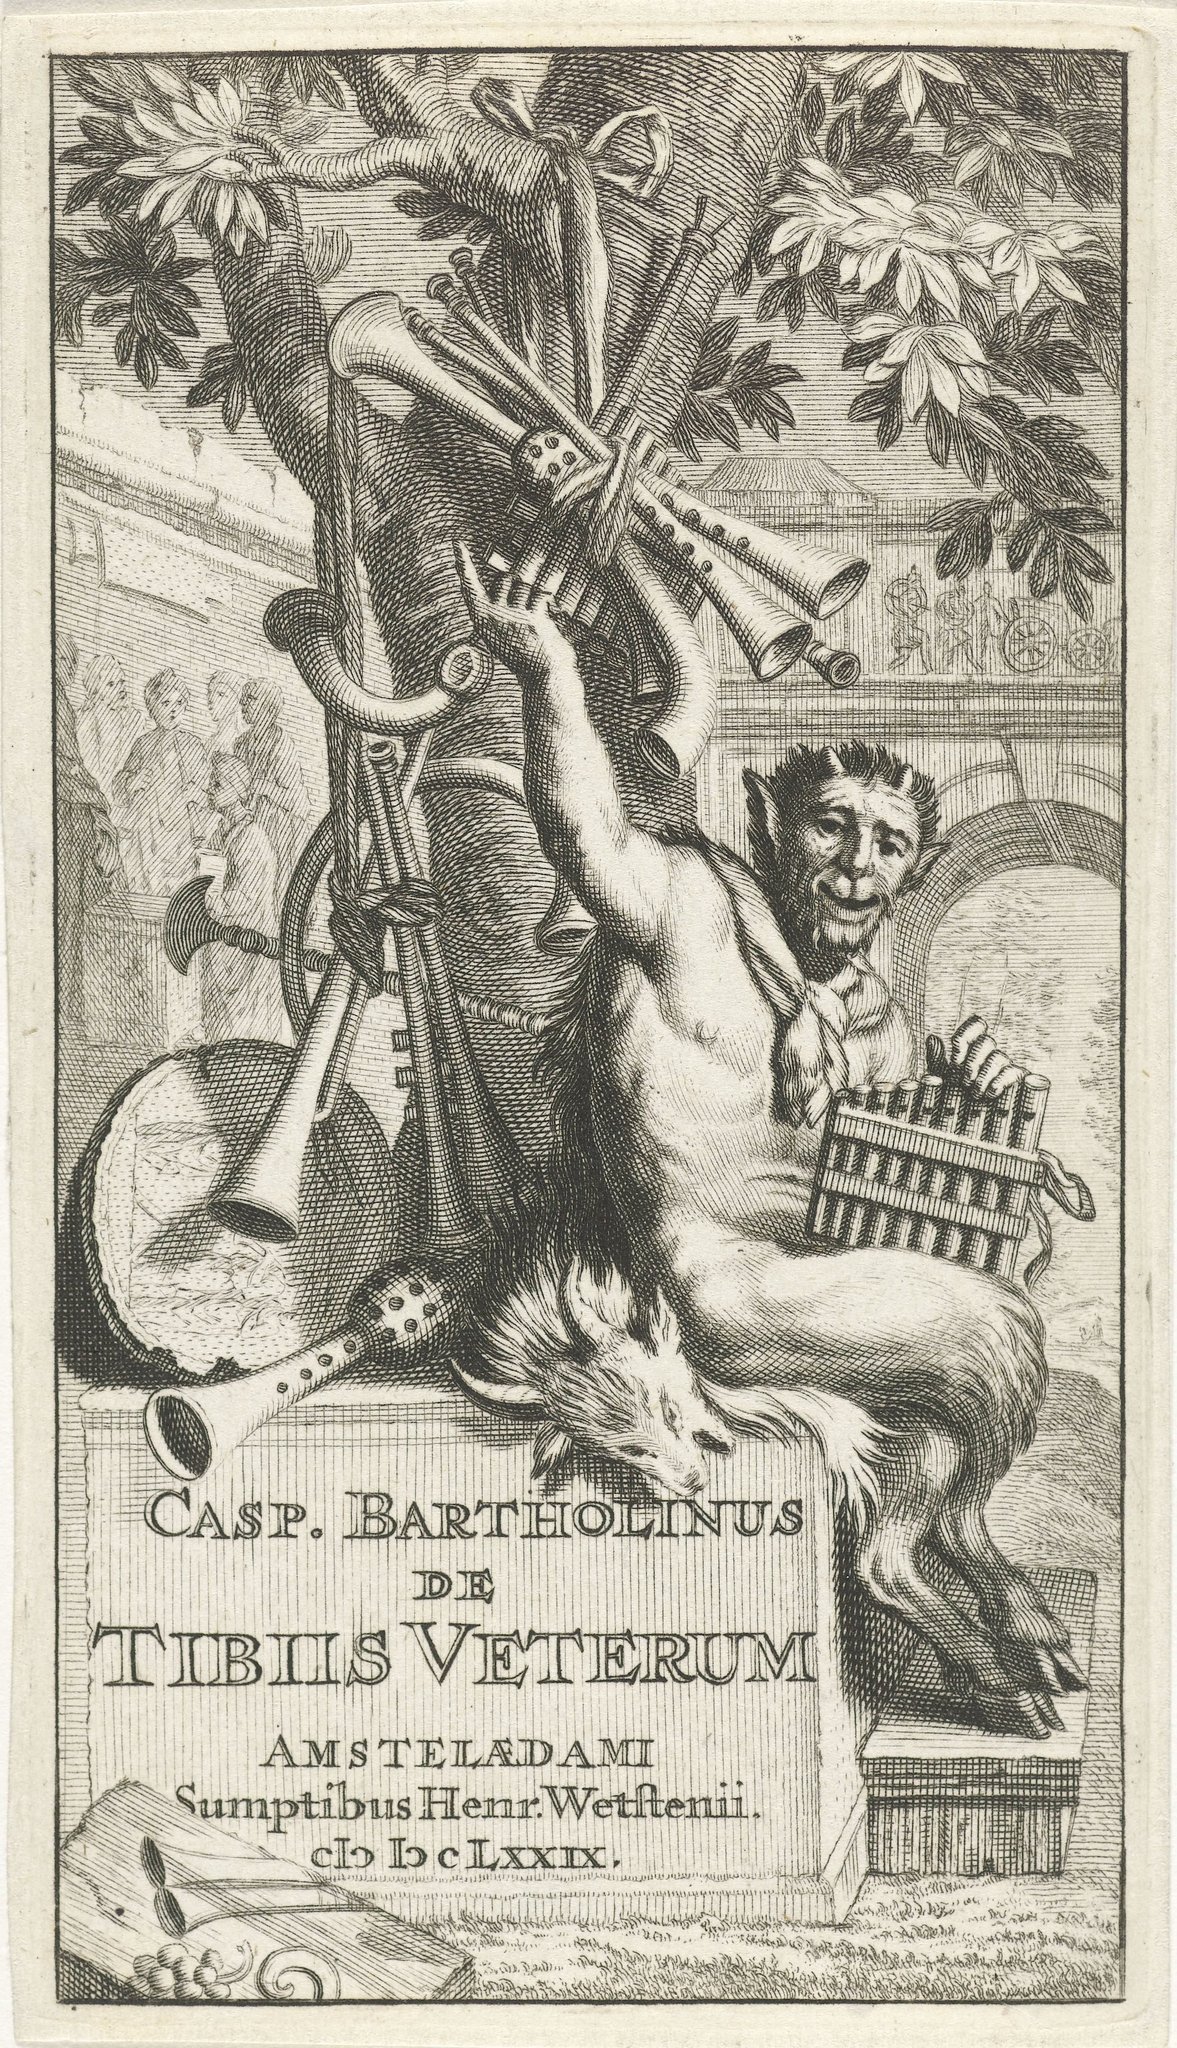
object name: titelblad, titelpagina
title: Titelpagina voor: C. Bartholinus, De tibiis veterum, et earum antiquo usu libri tres, 1679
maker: gerard de lairesse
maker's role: draughtsman, painter, print maker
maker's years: 1641-1711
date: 1679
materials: paper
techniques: etching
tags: musical instruments; group of musical instruments, (story of) pan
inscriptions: collector's mark: Lugt 240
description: Een sater zit met een panfluit in zijn handen onder een boom waarin muziekinstrumenten zijn gehangen. Ook naast hem liggen diverse muziekinstrumenten.